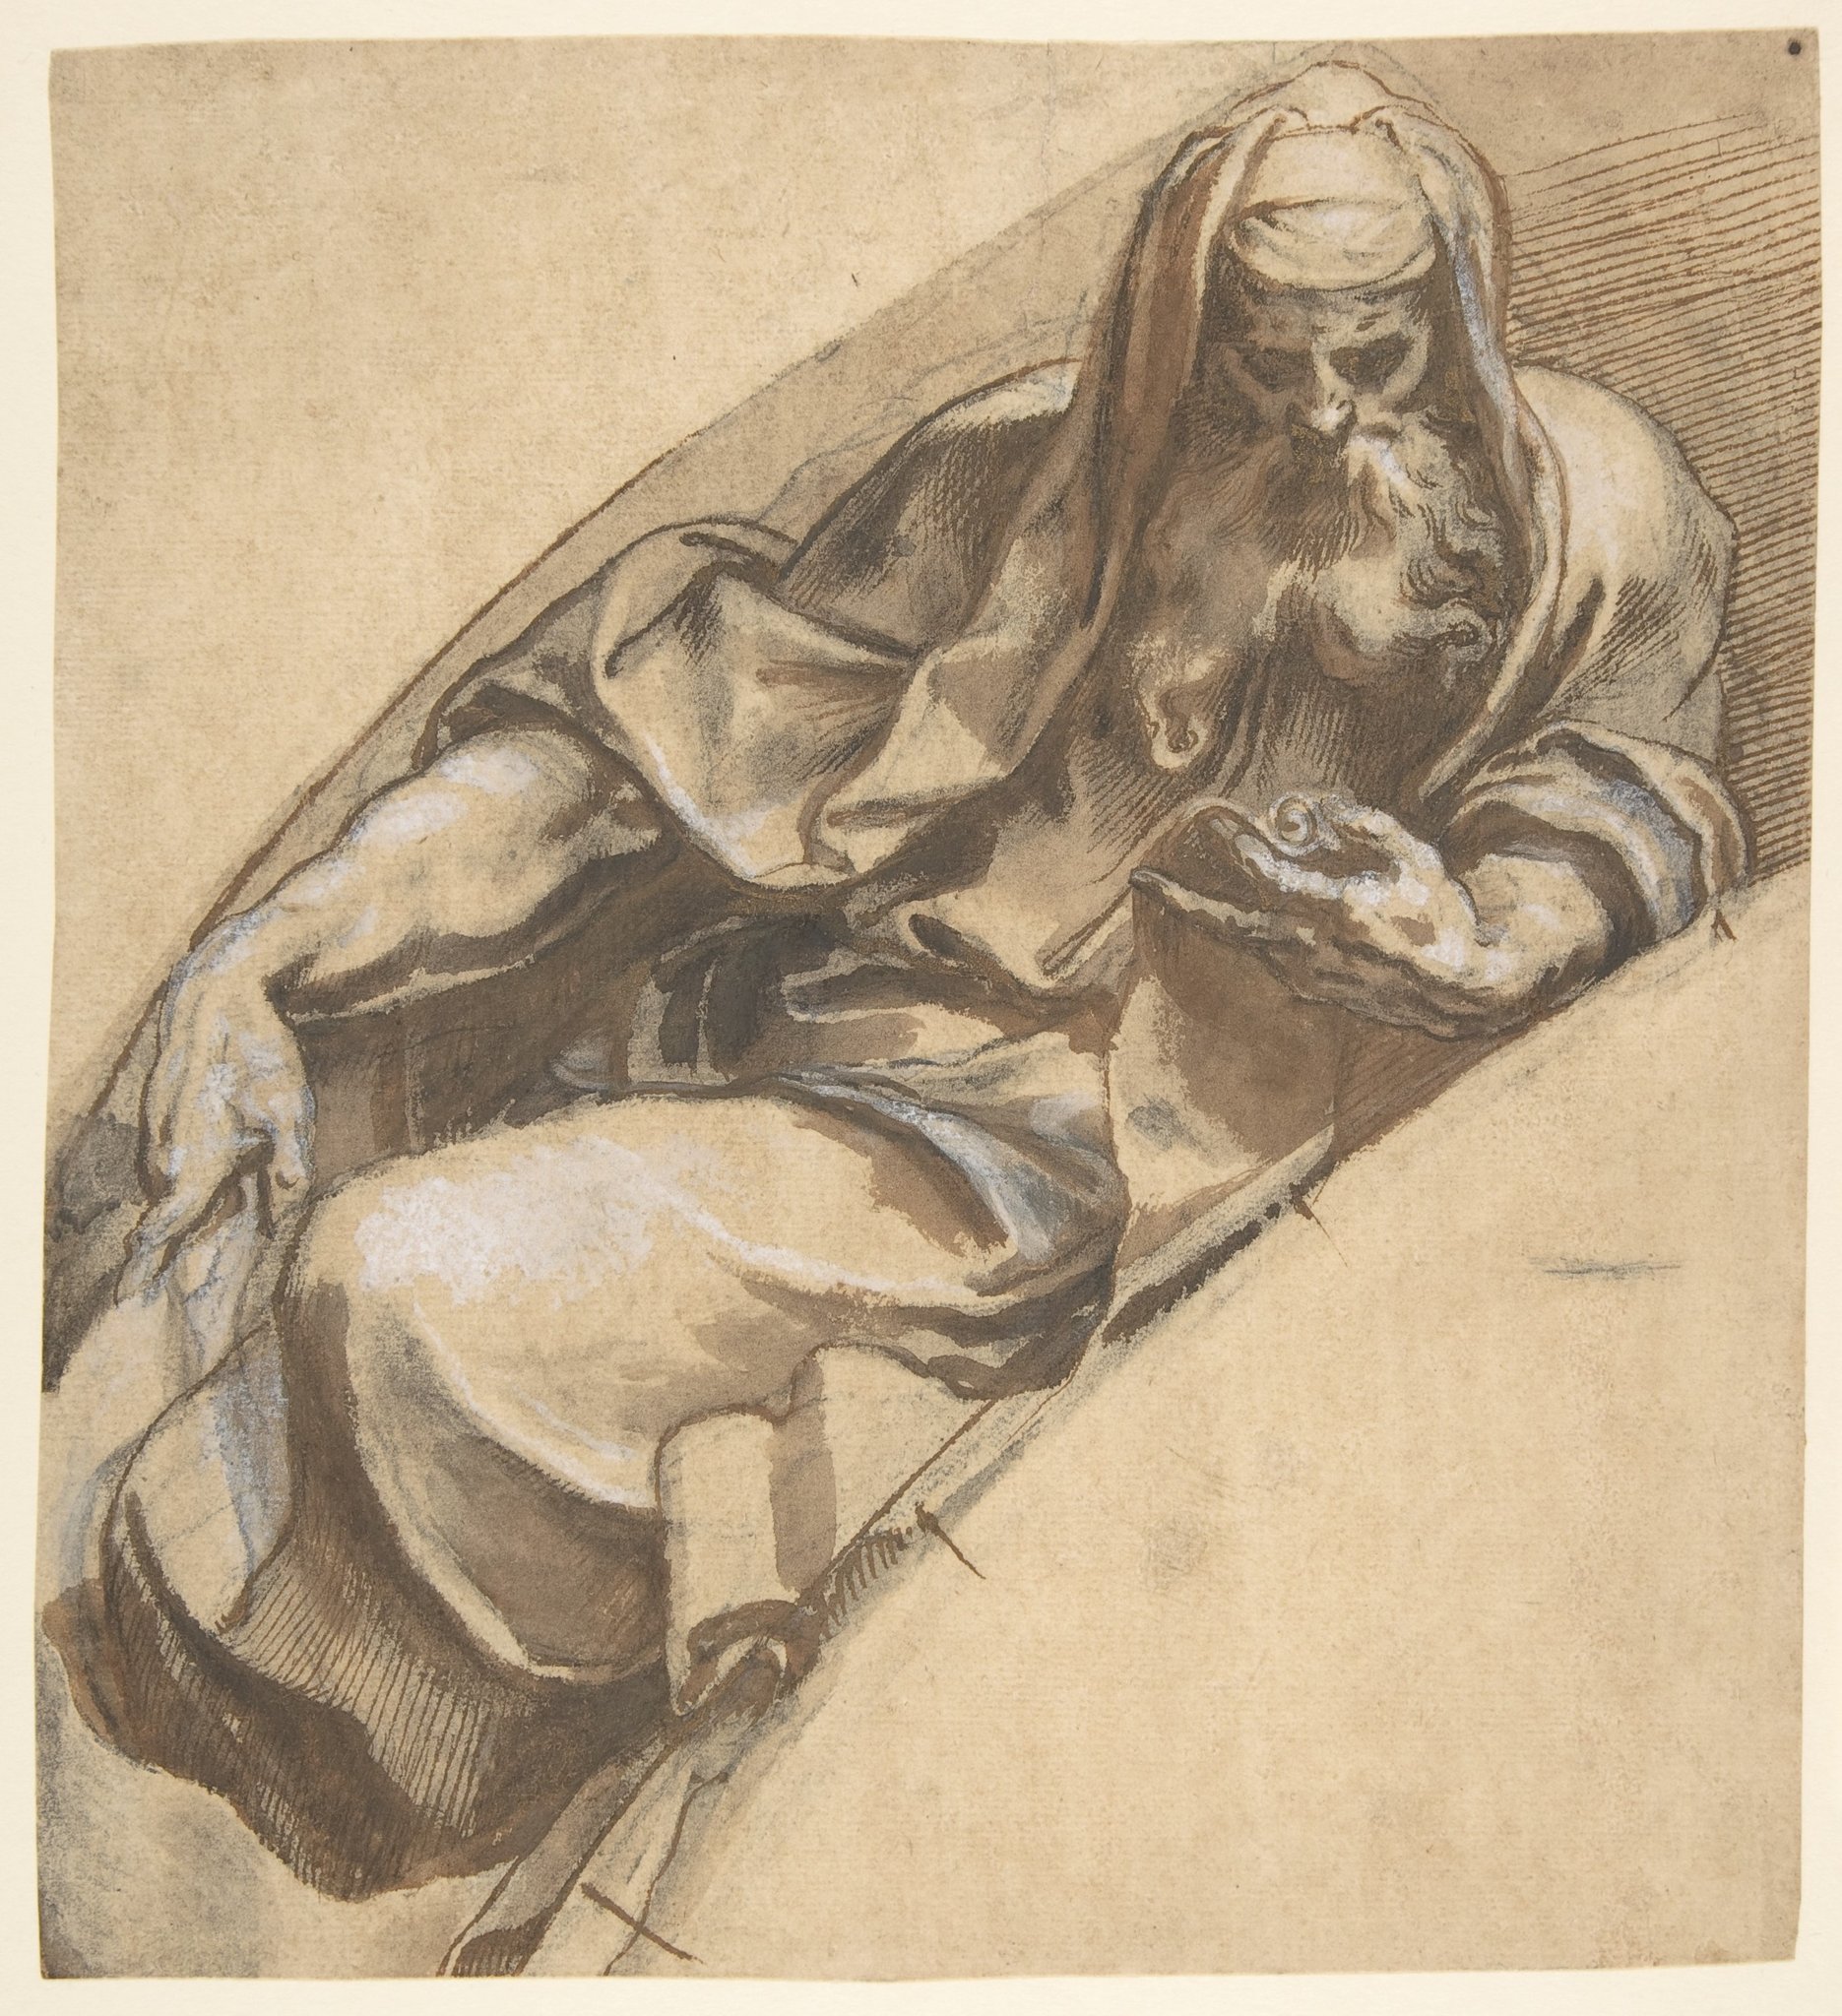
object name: drawing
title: Seated, Bearded Man Holding a Banderole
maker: paolo farinati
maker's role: artist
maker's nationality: italian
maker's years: 1524-1606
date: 1524-1606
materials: chalk, ink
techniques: highlighting, pen, wash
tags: men,flags